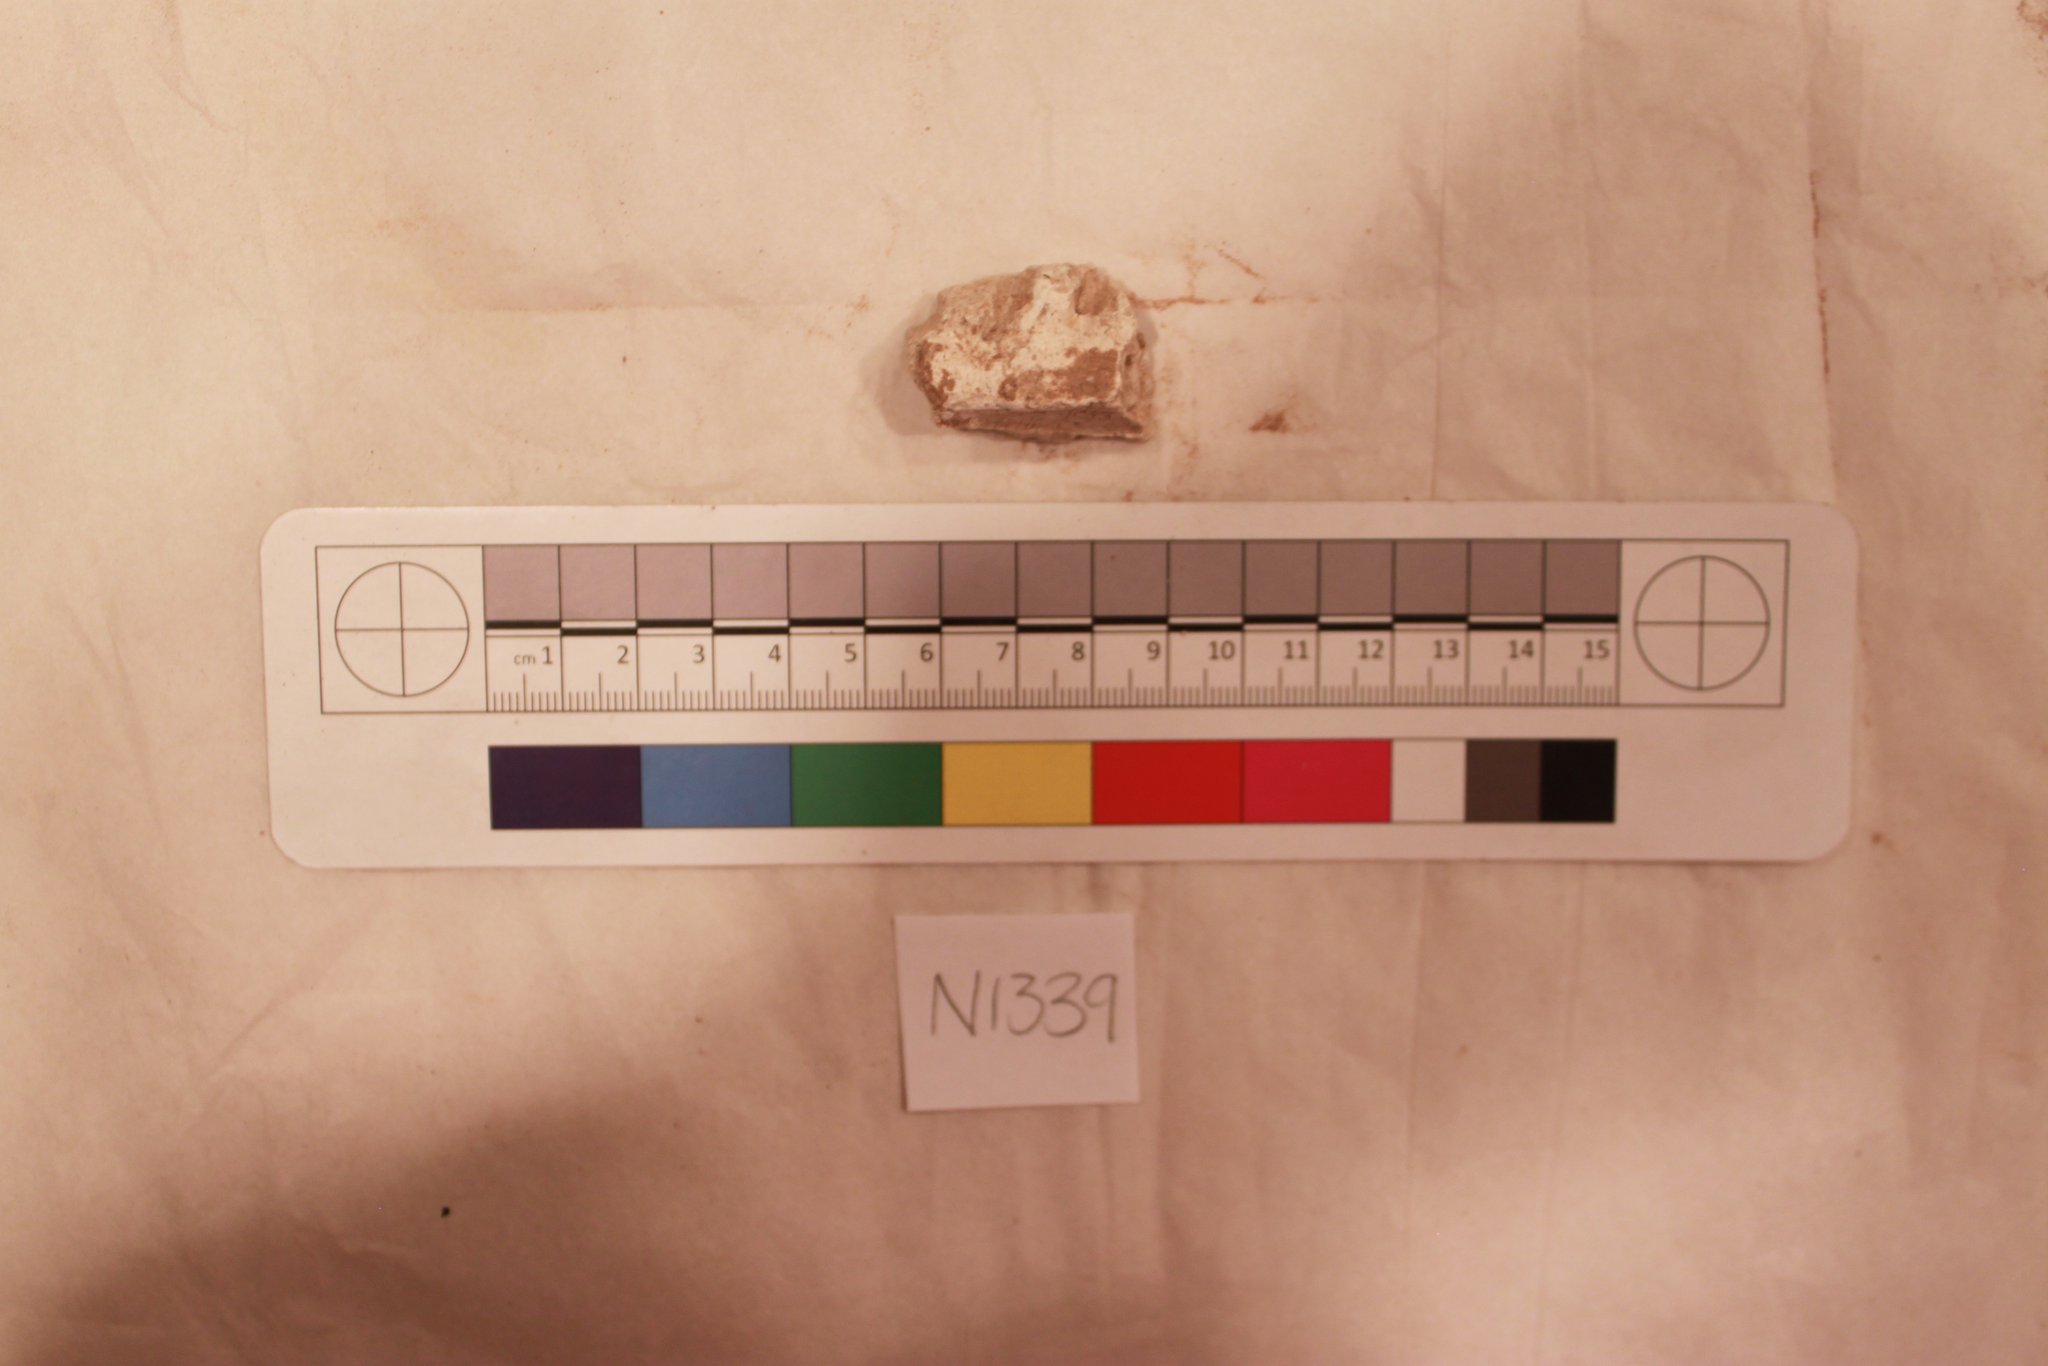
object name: fragment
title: Stucco Fragment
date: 701-1200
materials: plaster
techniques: carving, painting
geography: iran